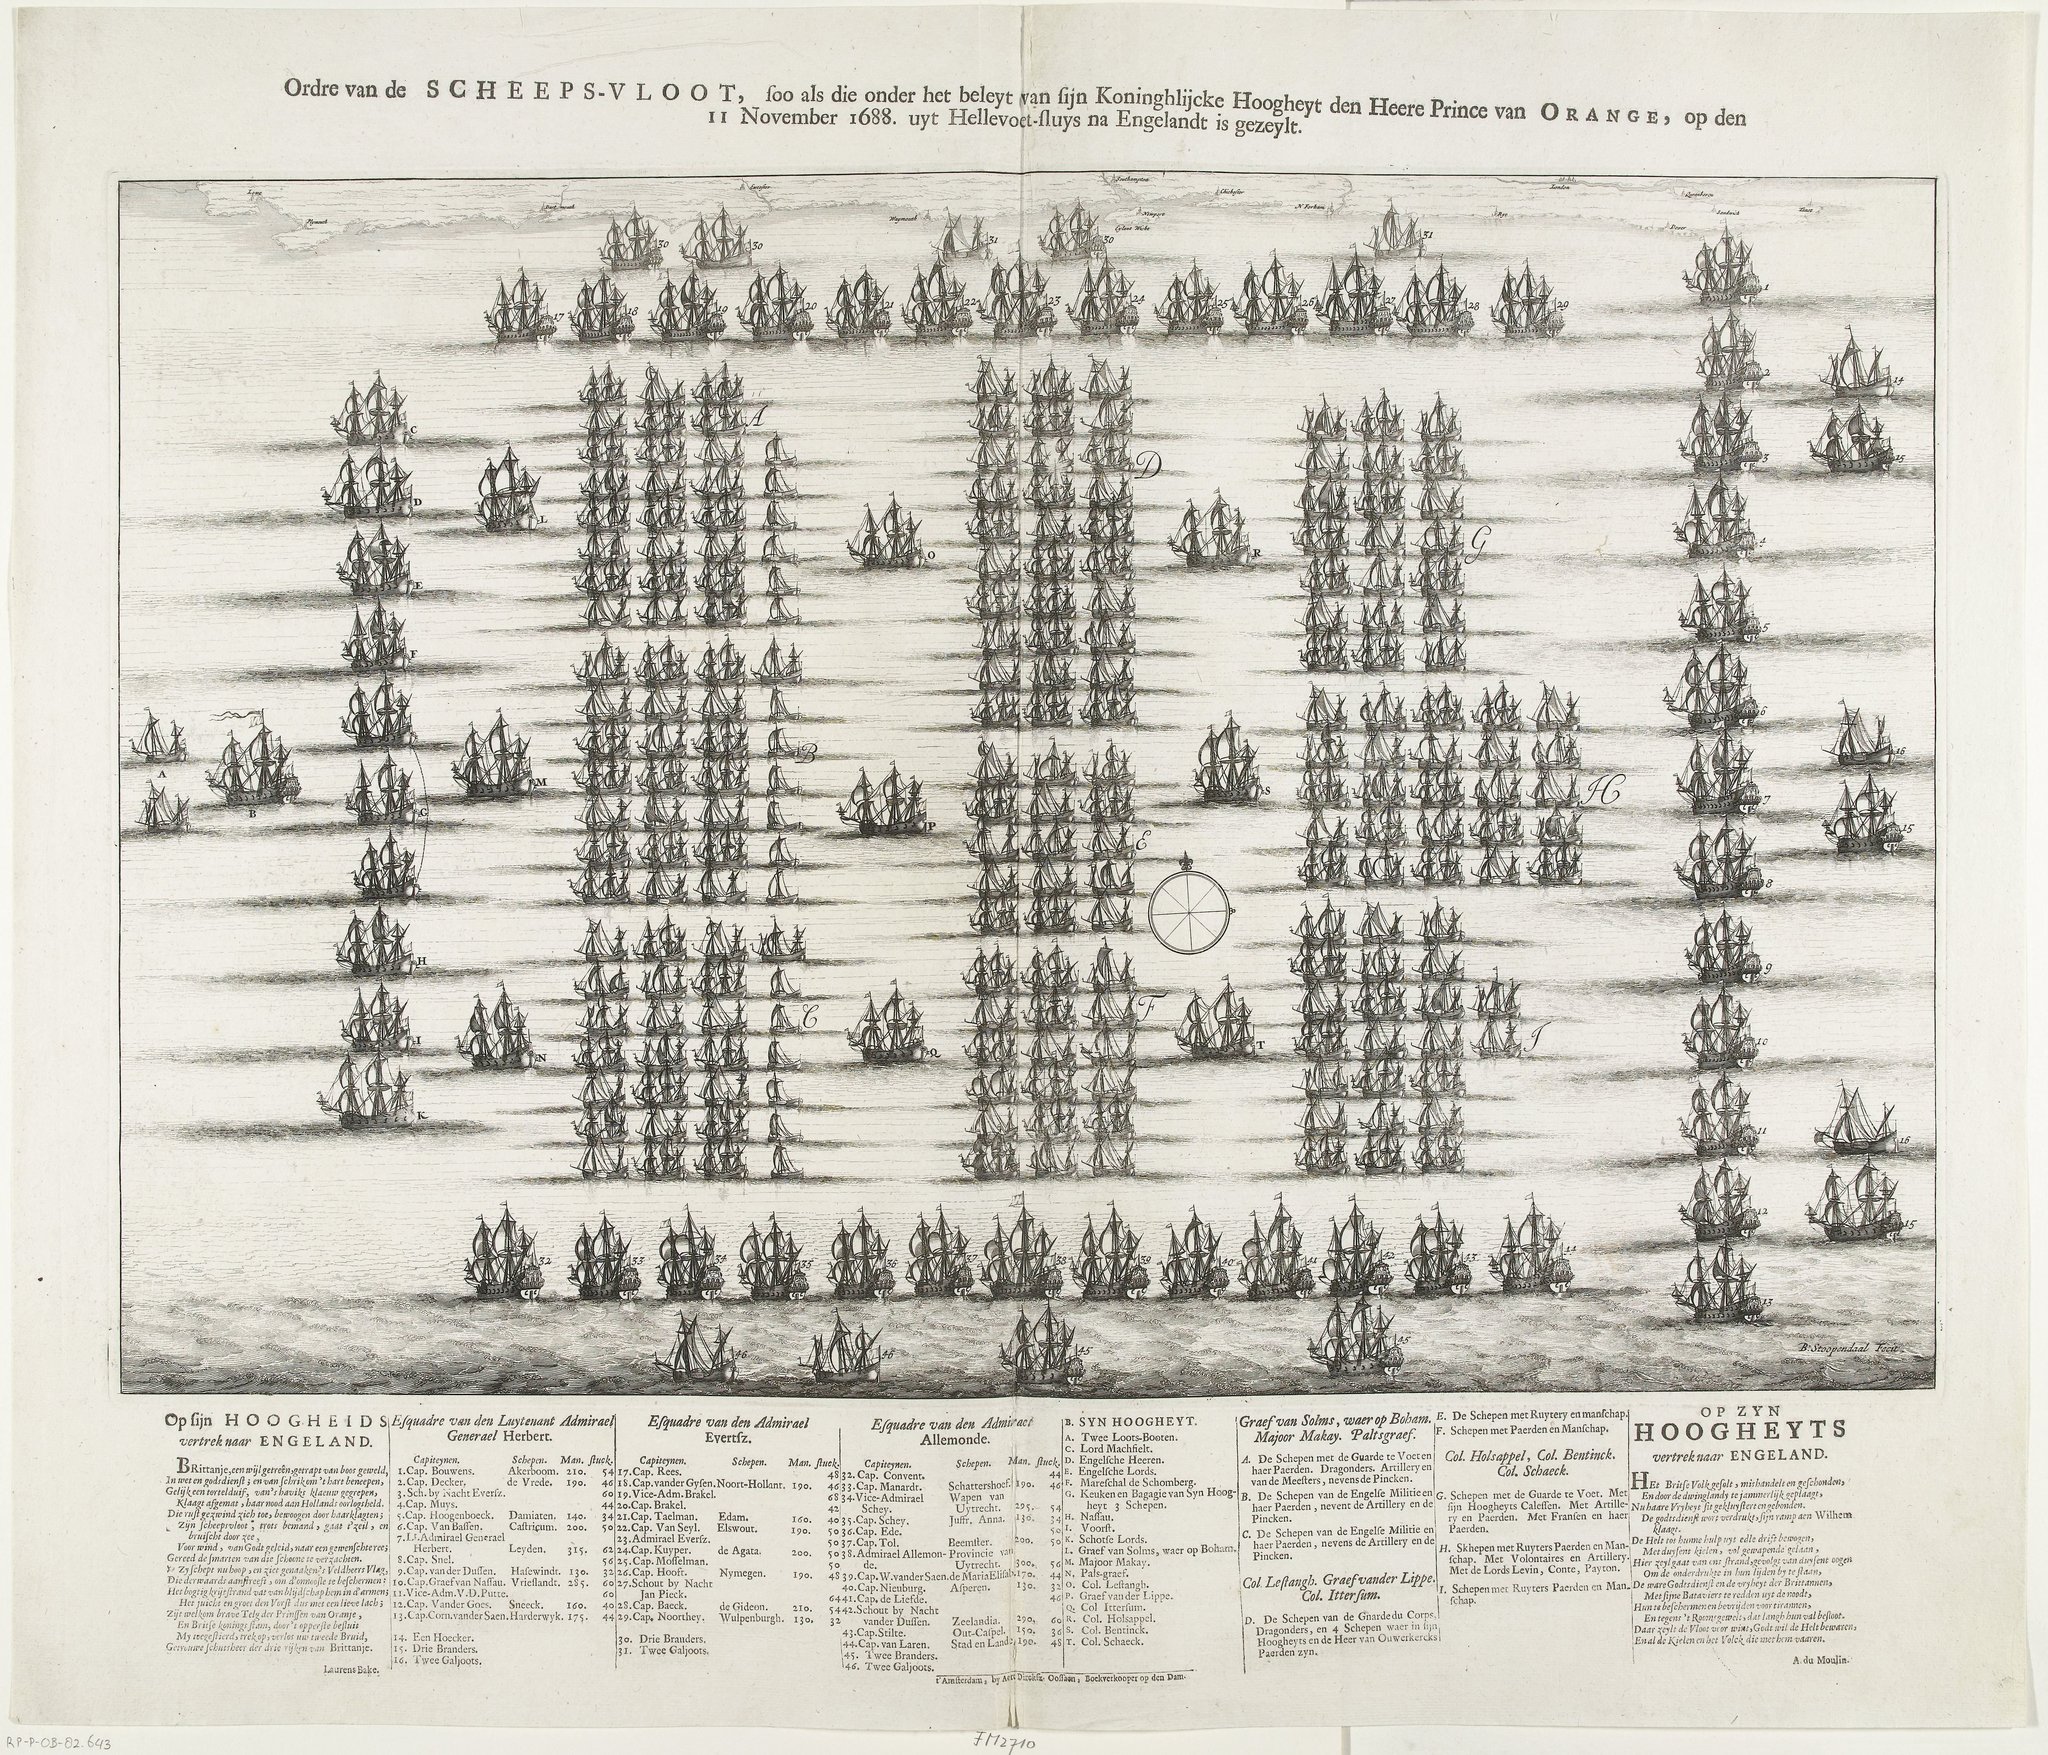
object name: print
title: Ordre van de Scheeps-vloot, soo als die onder het beleyt van sijn Koninghlijcke Hoogheyt den Heere Prince van Orange, op den 11 November 1688, uyt Hellevoet-sluys na Engelandt is gezeylt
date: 1688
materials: paper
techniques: etching, letterpress printing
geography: amsterdam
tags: the hague, william iii (prince of orange and king of england, scotland, and ireland), warfare; military affairs (+ sailing-ships)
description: De formatie van de vloot waarmee prins Willem III vanuit Hellevoetsluis naar Engeland is vertrokken, 11 november 1688. Onder de plaat een lijst van de verschillende eskaders en kapiteins.